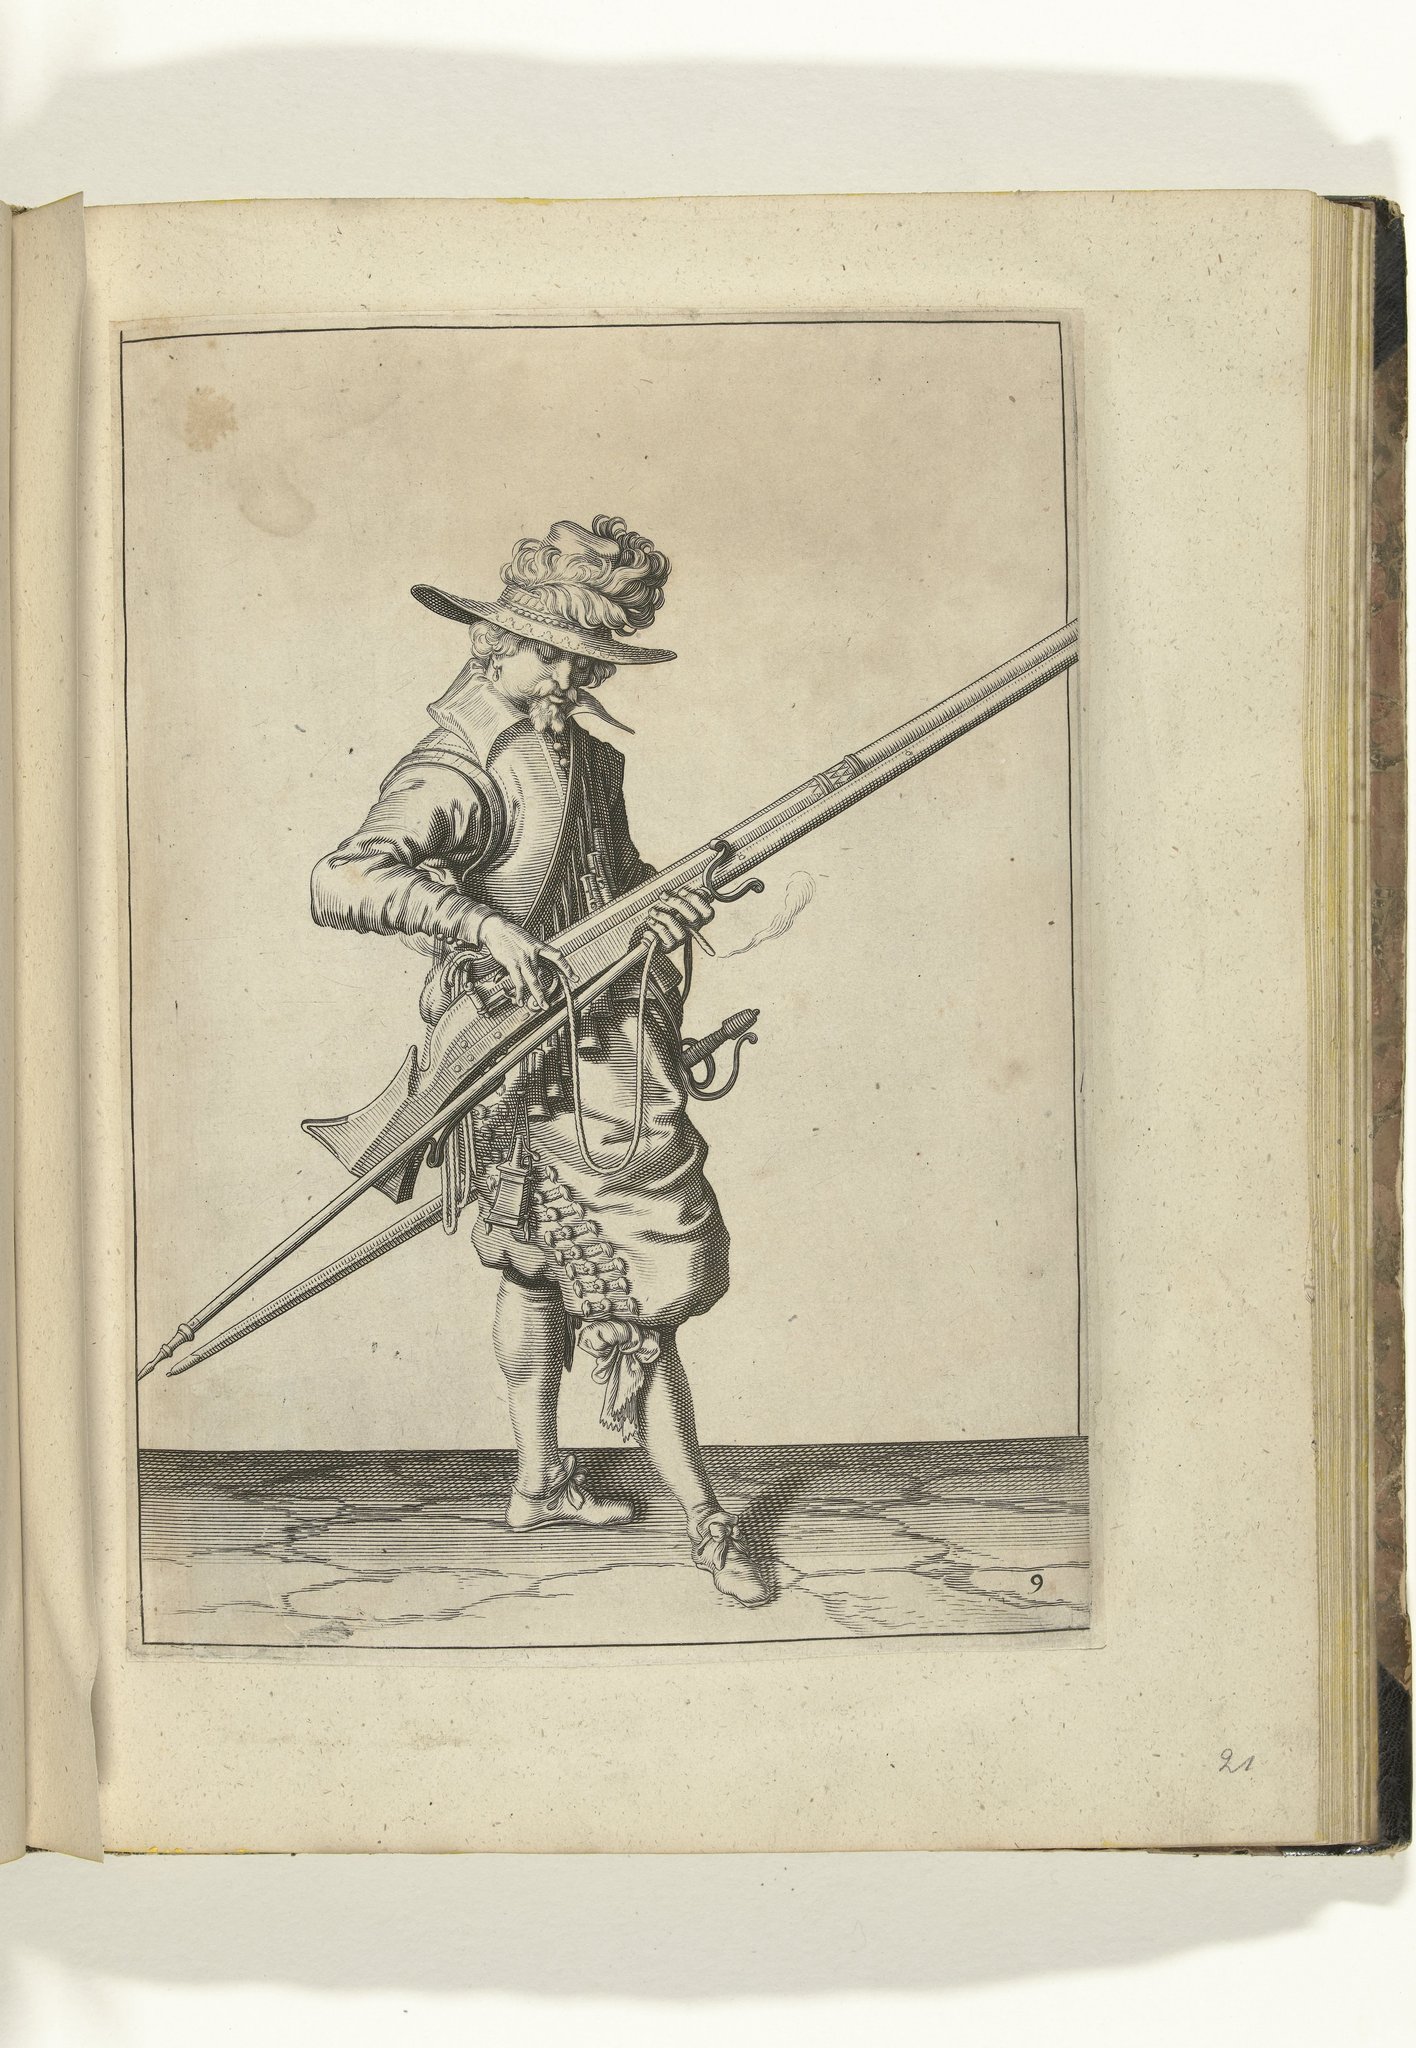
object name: print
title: Soldaat die de lont op de haan van zijn musket de juiste plek en vorm geeft (nr. 9), ca. 1600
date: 1597-1608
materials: paper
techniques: engraving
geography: northern netherlands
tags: the hague, maurice (prince of orange), handling of weapons ~ military training, weapons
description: Een soldaat, ten voeten uit, naar rechts, die een musket (een bepaald type vuurwapen) met zijn linkerhand vasthoudt (nr. 9), ca. 1600. Met duim en middelvinger van zijn rechterhand geeft hij de brandende lont op de haan (onderdeel van het ontstekingsmechanisme) van zijn musket de juiste plek en vorm. Plaat 9 in de instructies voor het hanteren van het musket: Shorte instruction for the figures, so much concerneth the right use of muskett. Onderdeel van de illustraties in een Engelse editie van J. de Gheyns Wapenhandelinghe: J. de Gheyn, The exercise of armes for calivres, muskettes and pikes after the ordre of Maurits Prince of Orange, 's-Gravenhage 1608. Krijgswezen rond 1600.